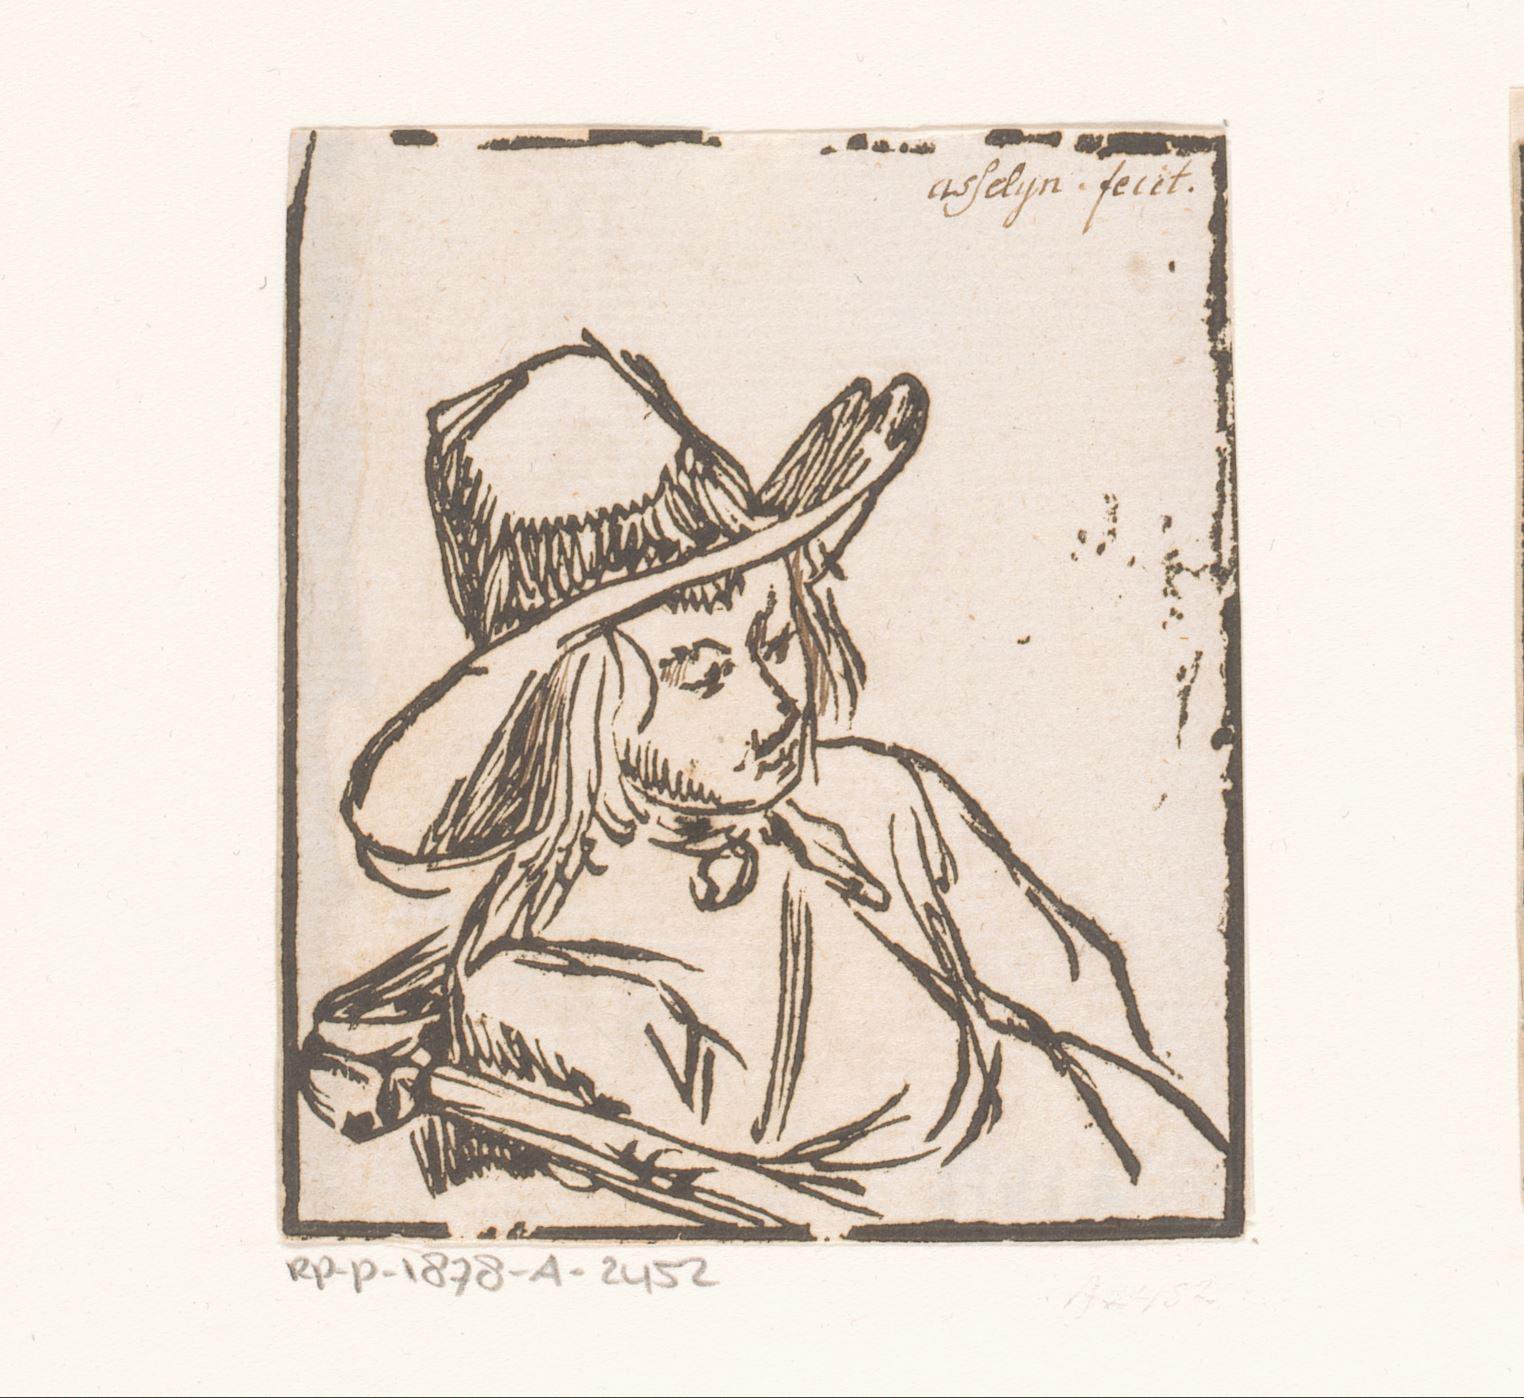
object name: print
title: Zittende man met een hoed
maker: Anonymous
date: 1684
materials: paper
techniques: woodcut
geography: netherlands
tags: adult man (+ sitting)